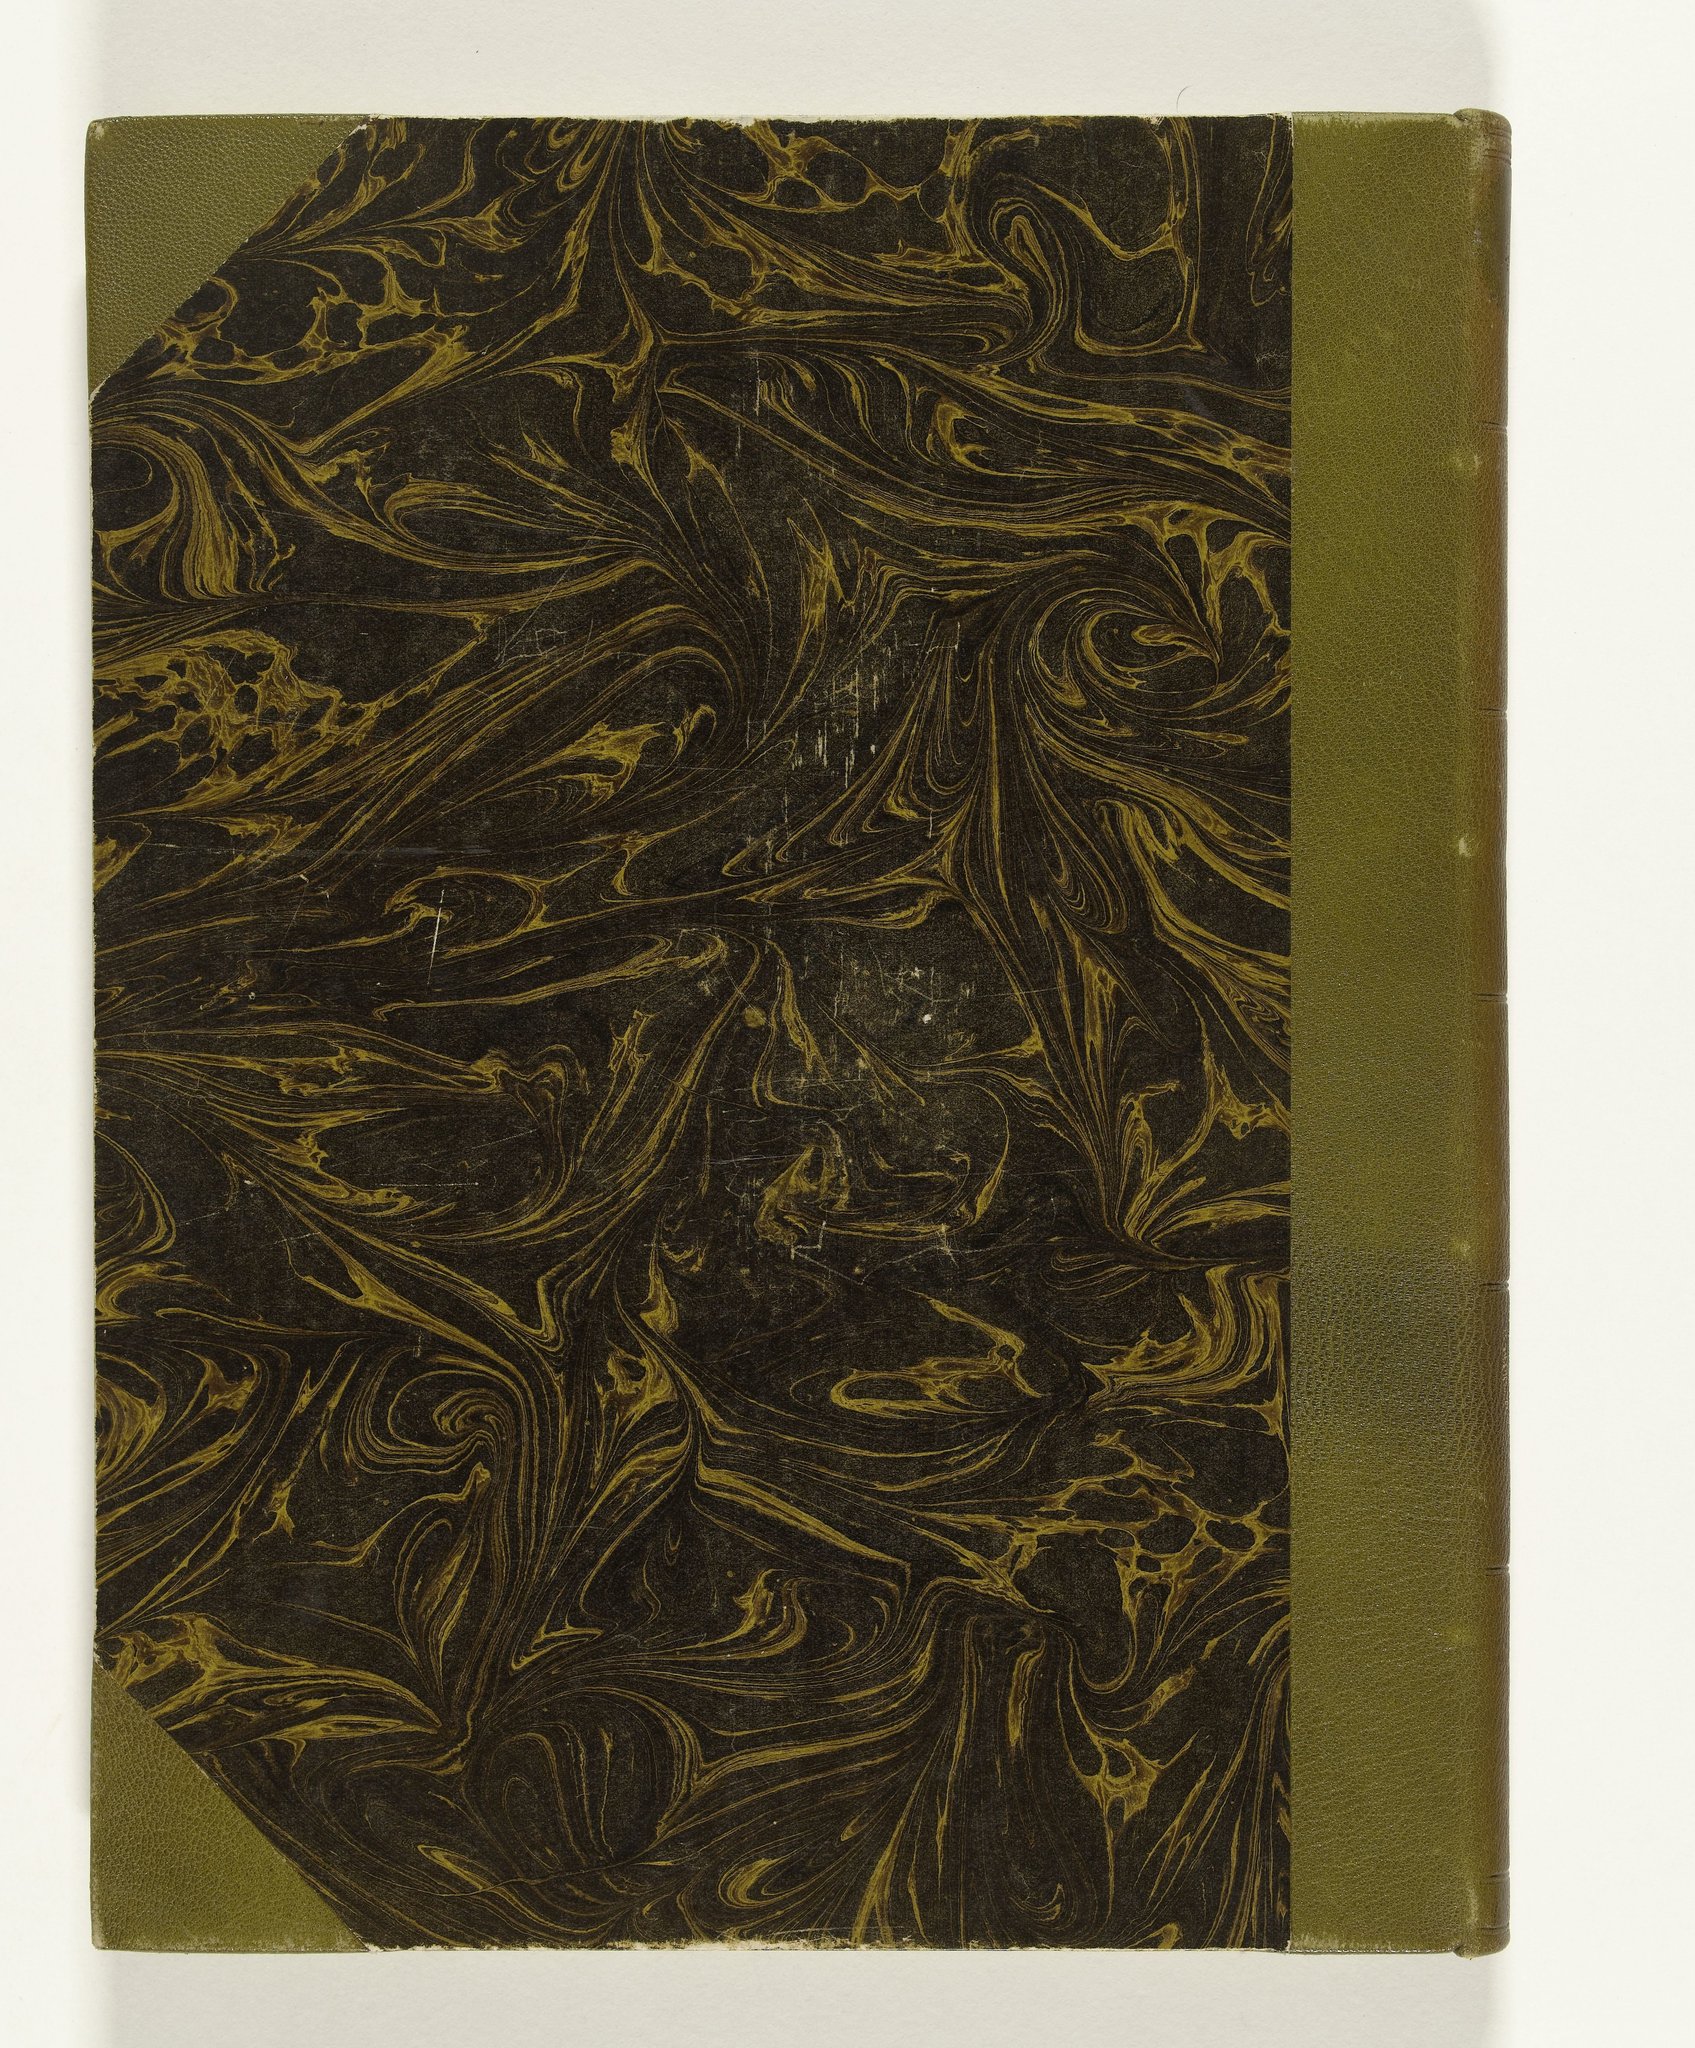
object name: book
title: Schetsen naar oude voorbeelden - textiel deel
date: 1878-1885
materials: paper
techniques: woodcut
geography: tokyo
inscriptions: label: ‘C.J. Mensing. Boekbinder Amsterdam’ Lugt 3937, collector's mark: ‘Rijksschool voor kunstnijverheidq’ Lugt 3937